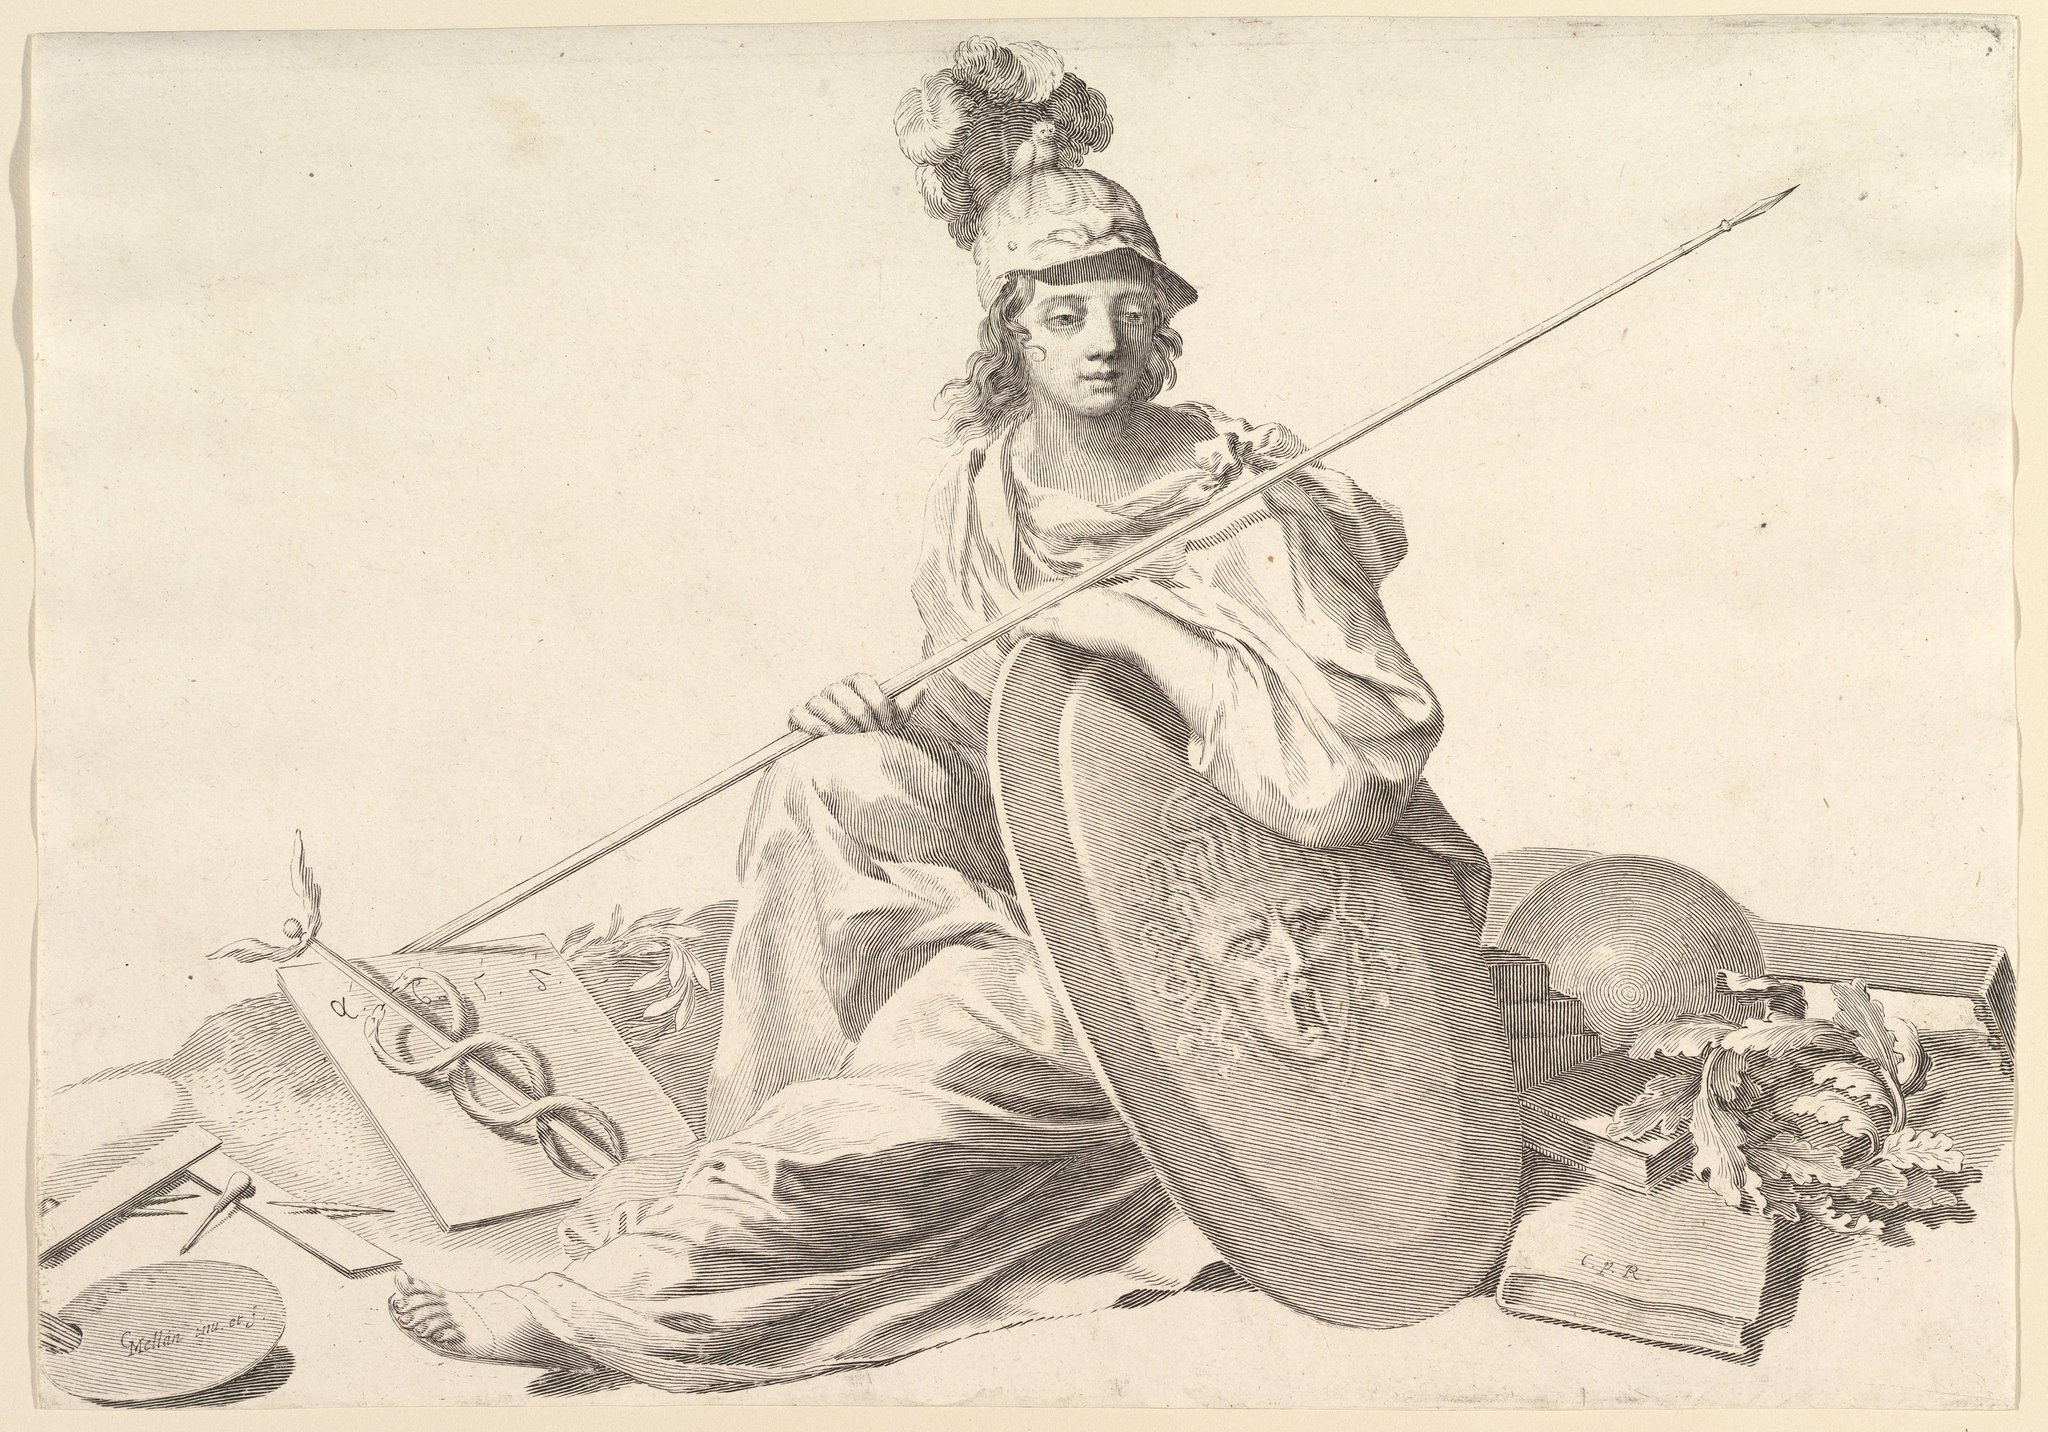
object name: print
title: Minerva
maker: claude mellan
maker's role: artist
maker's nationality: french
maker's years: 1598-1688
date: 1600-1688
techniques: engraving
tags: weapons,minerva